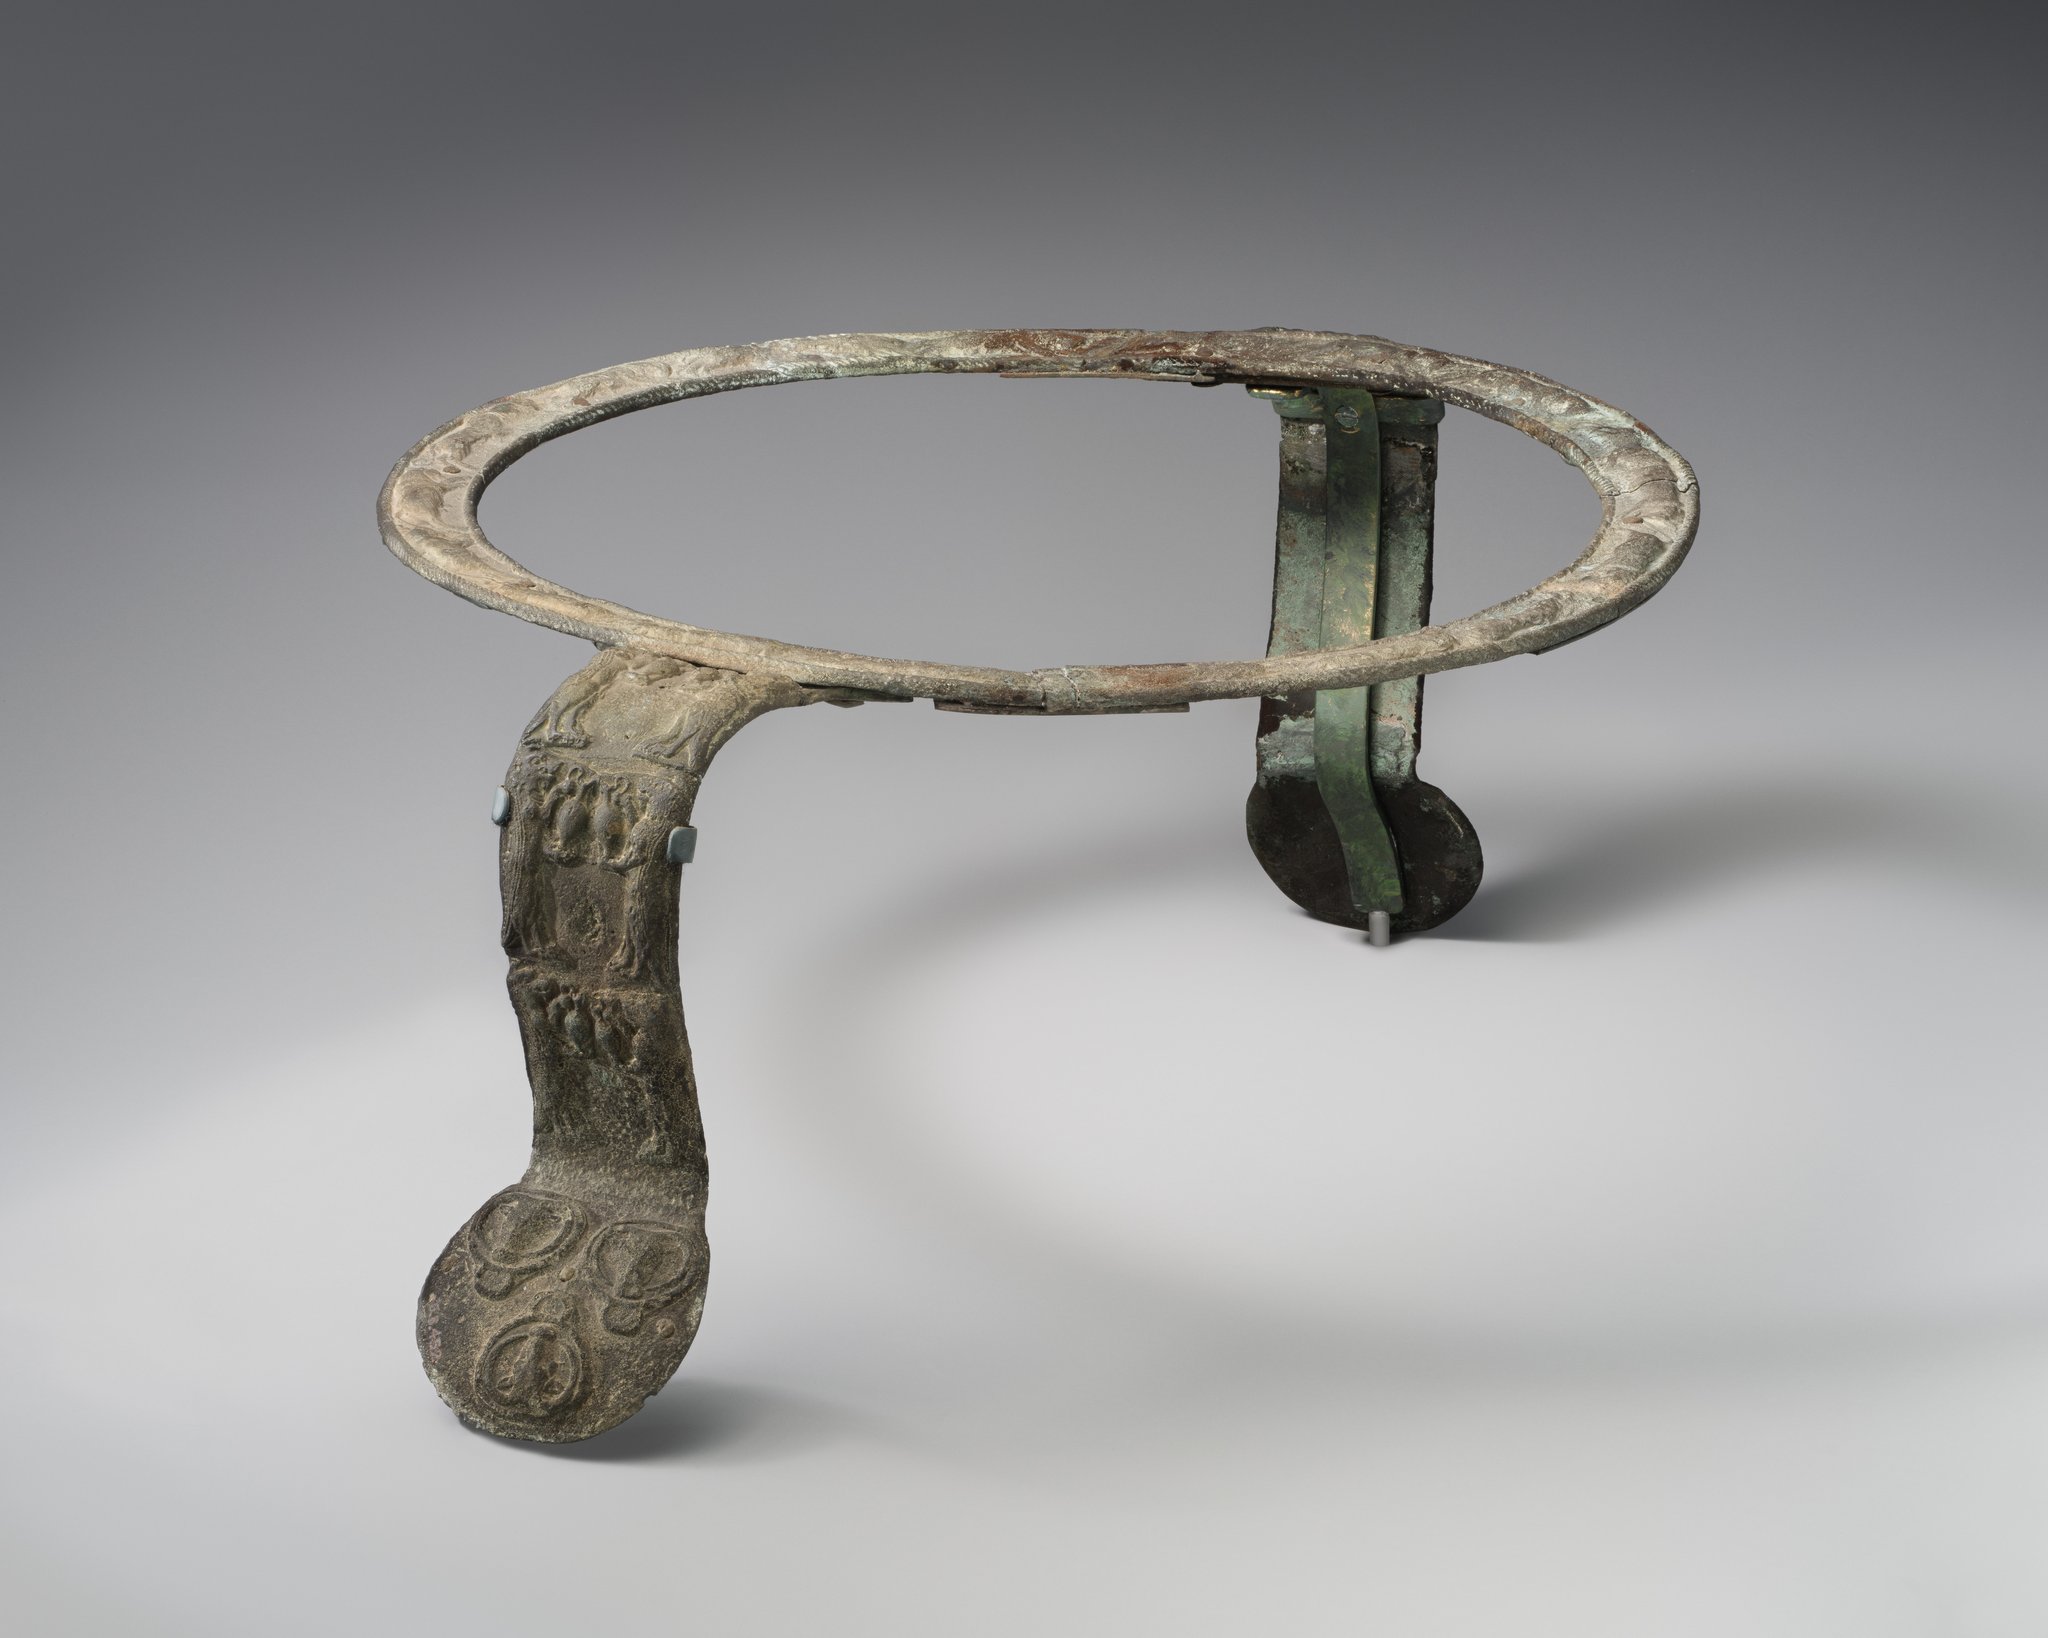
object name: handle and rim of a cauldron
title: Bronze handles and rim of a cauldron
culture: cypriot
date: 1300-1050 BCE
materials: bronze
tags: lions